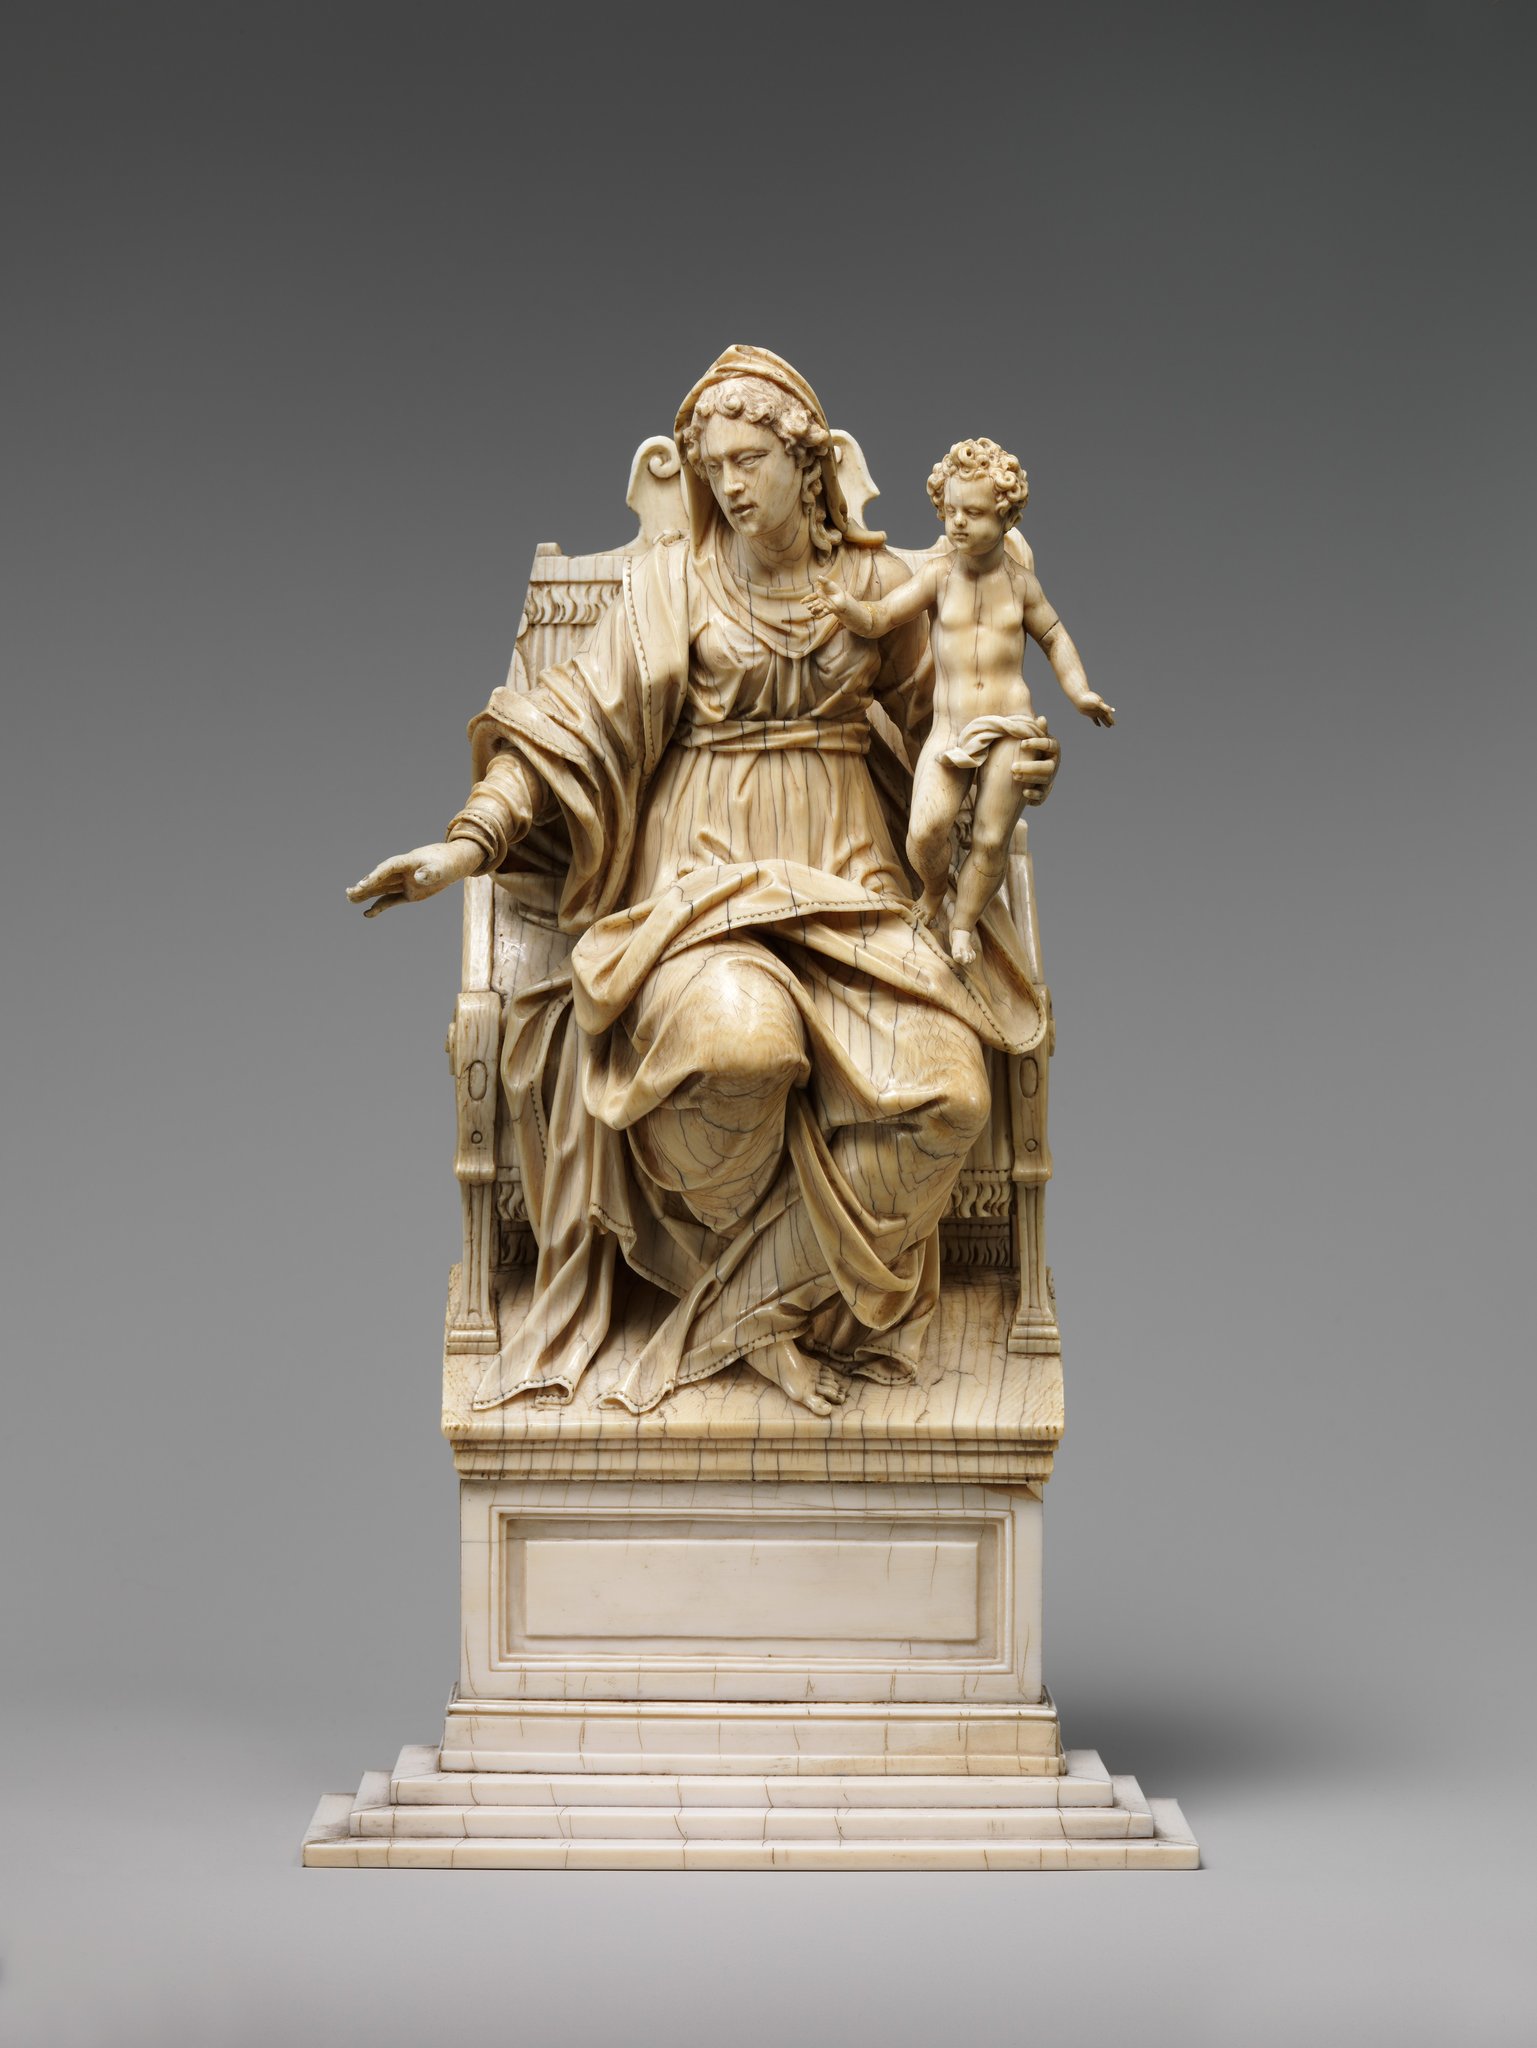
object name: statuette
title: Virgin and Child Enthroned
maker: christoph angermair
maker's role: artist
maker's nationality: german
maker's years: 1580-1633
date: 1600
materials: ivory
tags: madonna and child